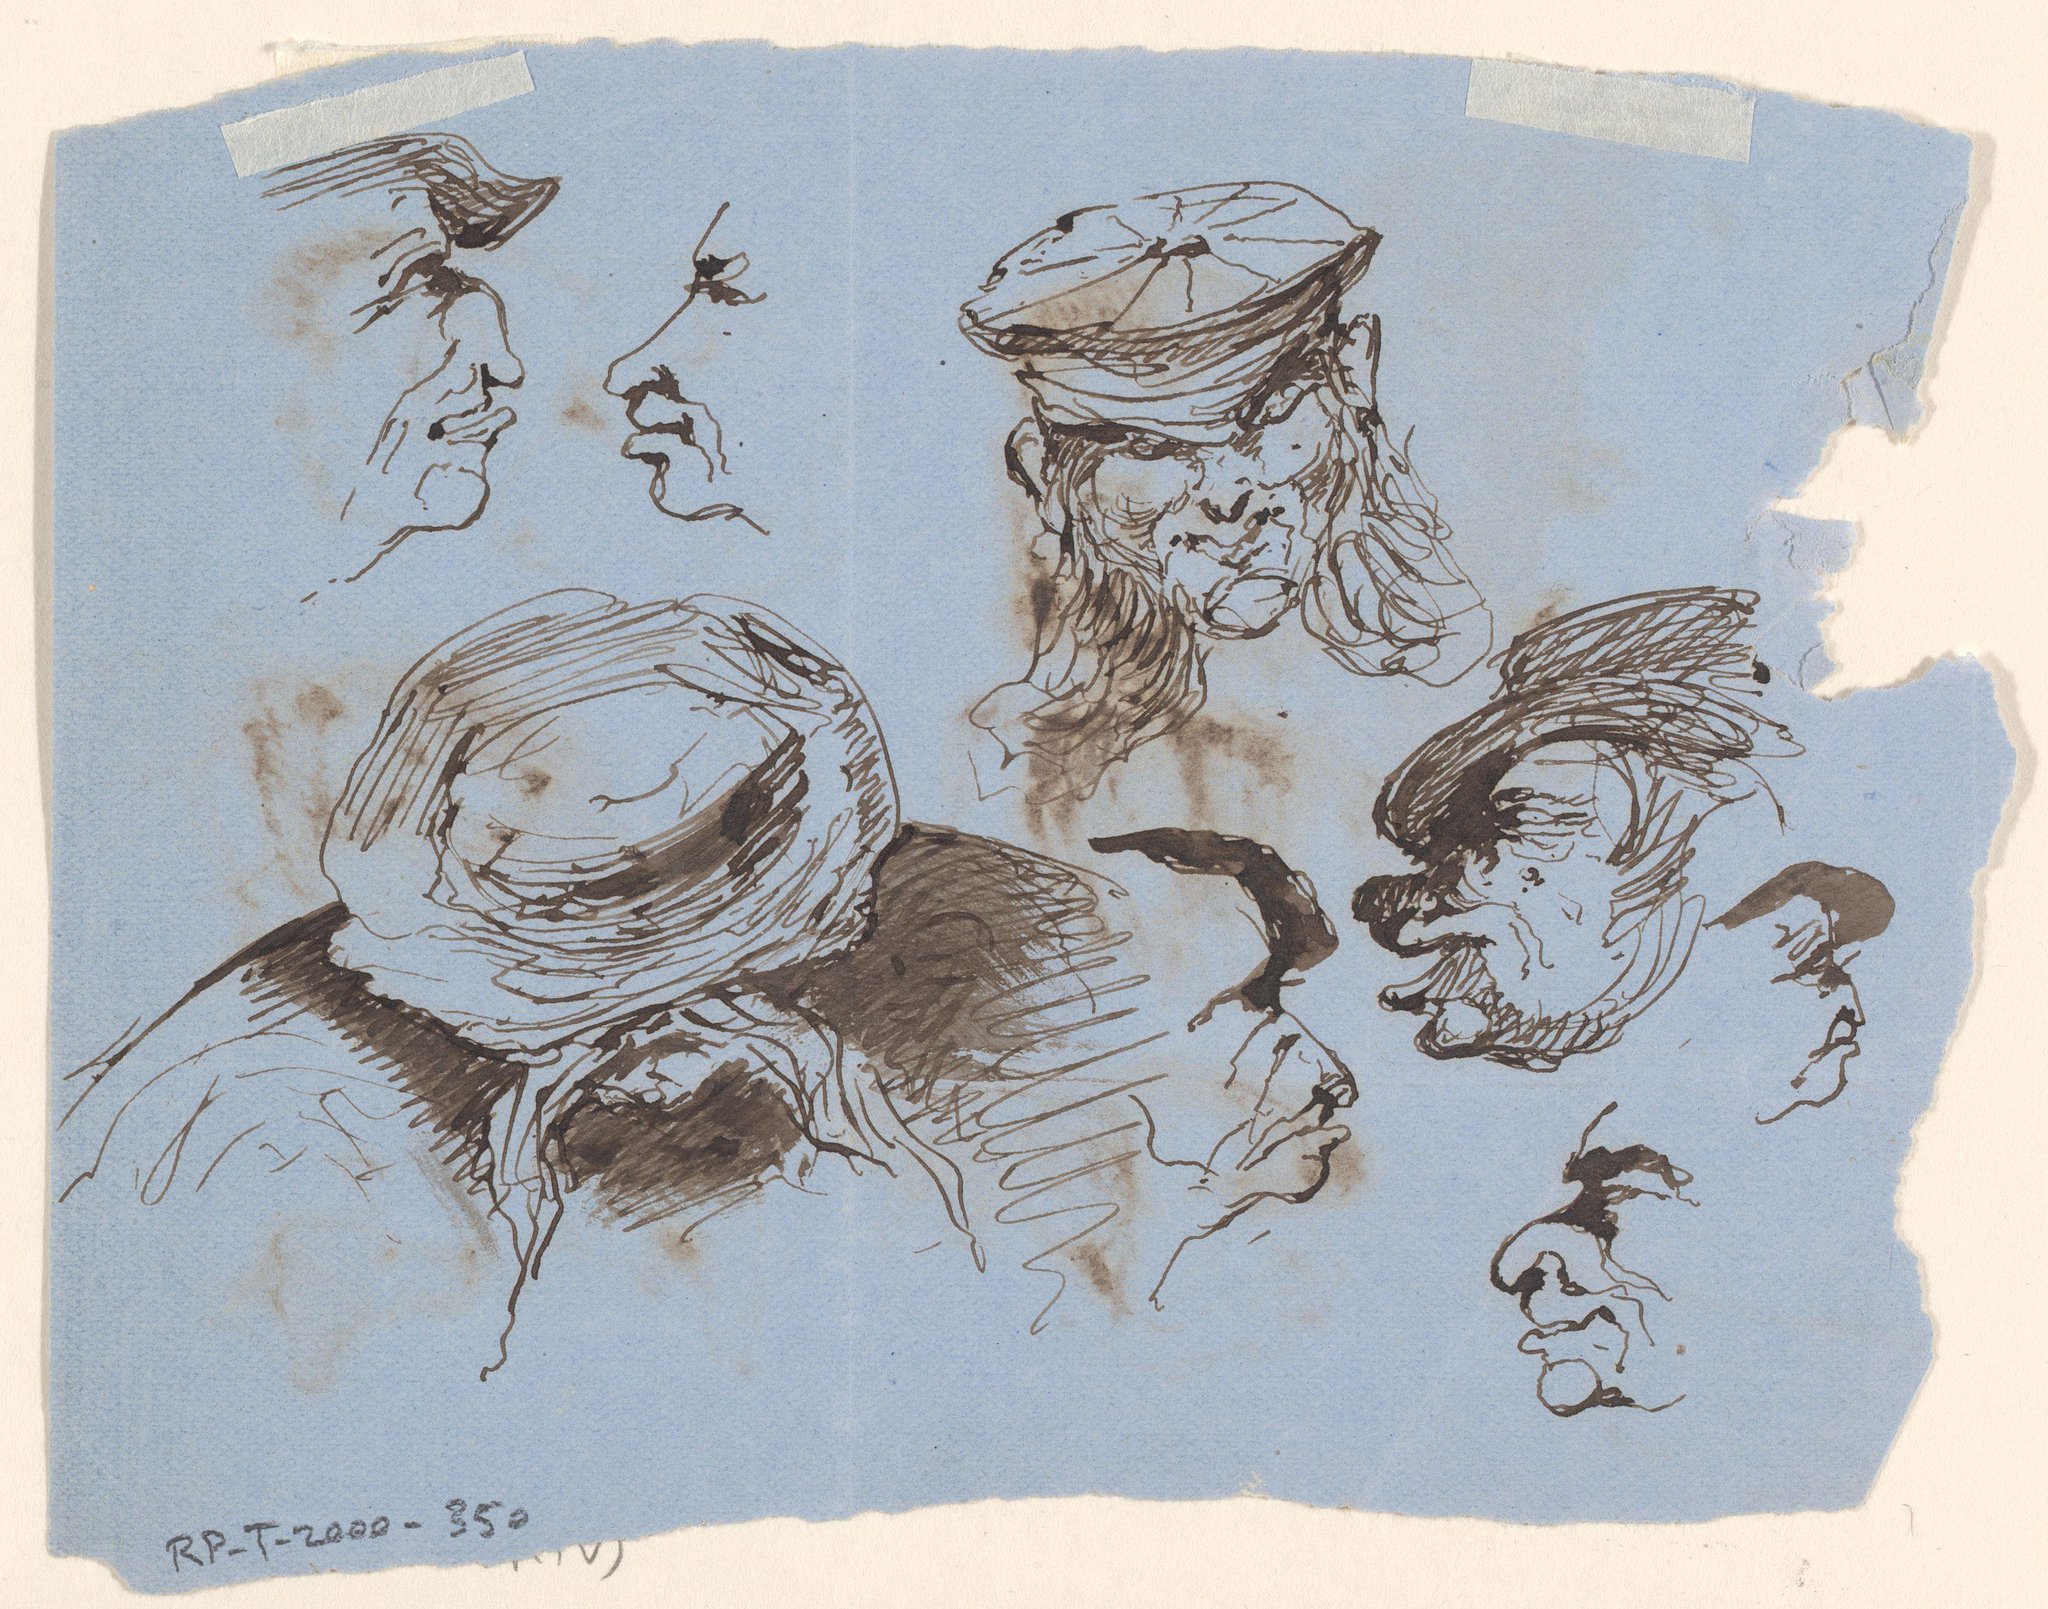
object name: drawing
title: Koppen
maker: johannes tavenraat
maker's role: draughtsman, painter, print maker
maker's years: 1809-1881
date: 1840-1880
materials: ink, paper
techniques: brush, pen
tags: caricatures (human types)